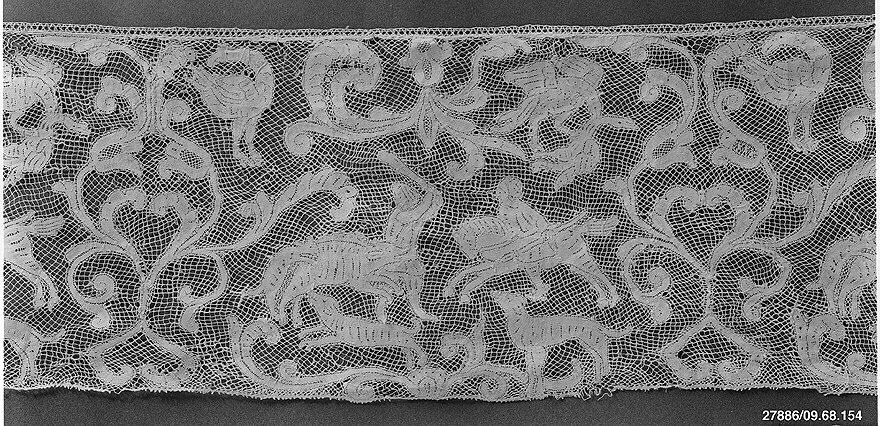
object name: piece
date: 1701-1733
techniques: lace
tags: hunting,boars,dogs,horses